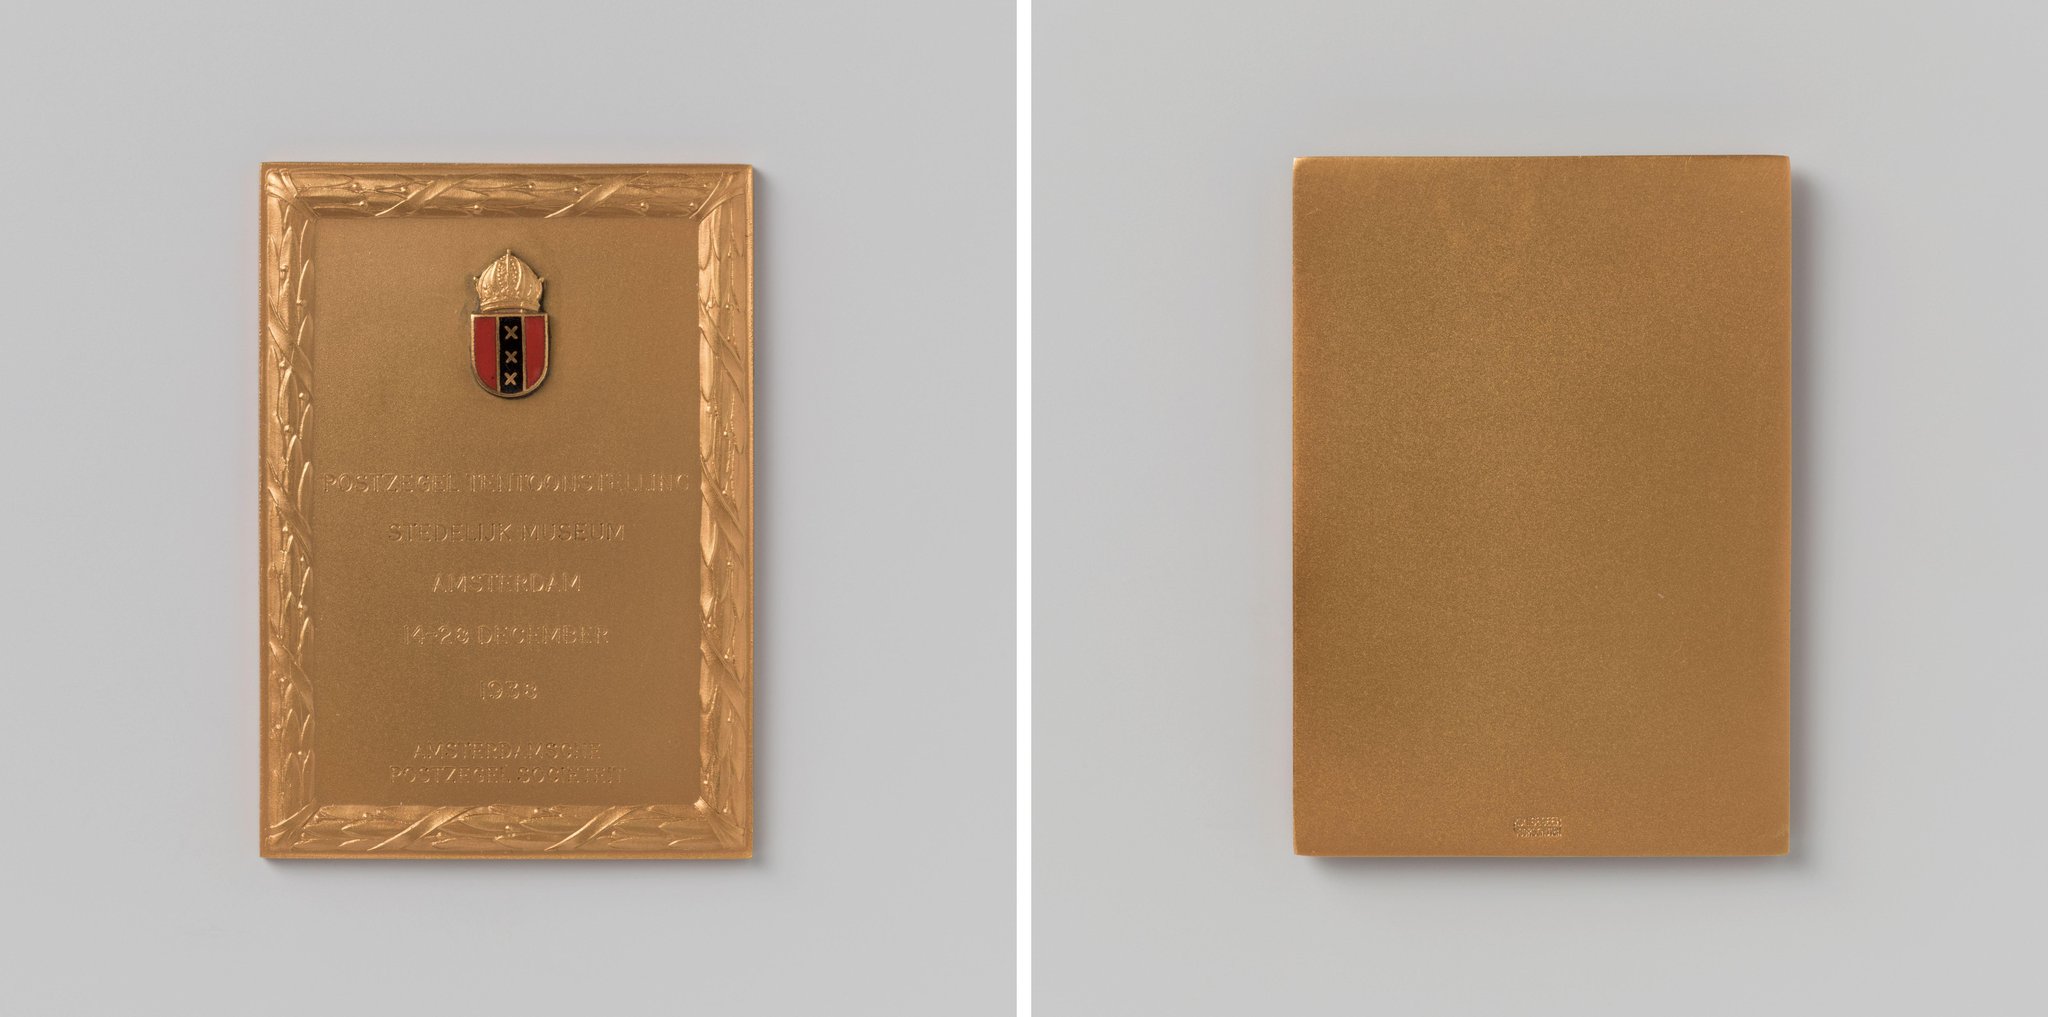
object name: plaque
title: Postzegeltentoonstelling Stedelijk Museum Amsterdam 1938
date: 1938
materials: bronze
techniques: engraving, gilding, striking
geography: voorschoten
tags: amsterdam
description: Plaquette Voorzijde: Binnen een rechthoekige, met lint omwonden lauwerkrans het gegraveerde opschrift: POSTZEGELTENTOONSTELLING STEDELIJK MUSEUM AMSTERDAM 14-28 DECEMBER 1938 AMSTERDAMSCHE POSTZEGEL SOCIETEIT. Daarboven het in zwart en rood geëmailleerde wapen van Amsterdam. Op onder zijkant: "BRONS".